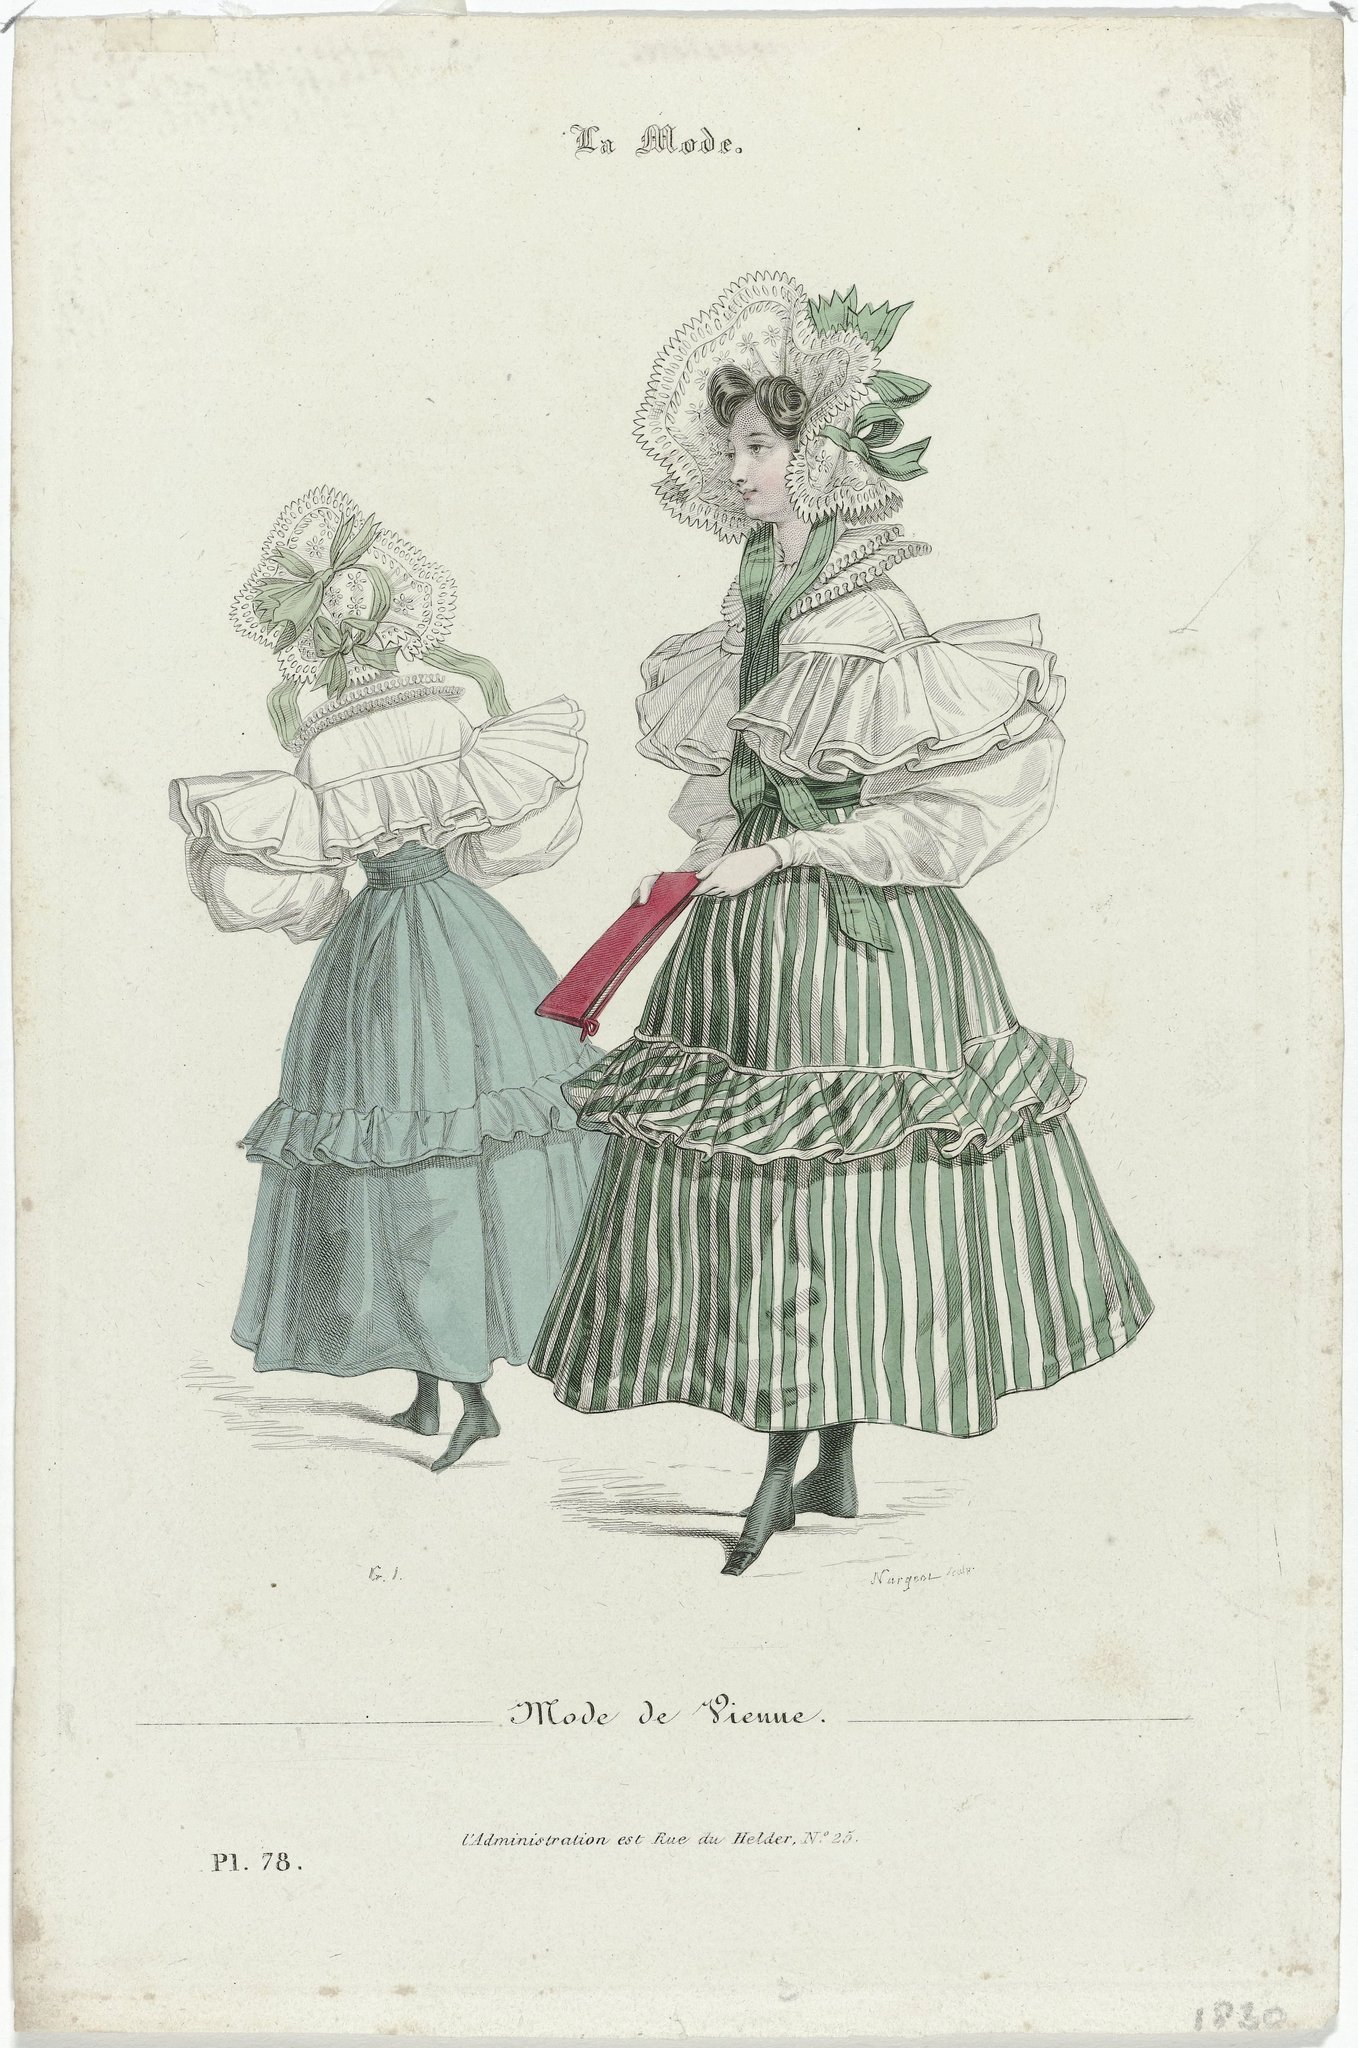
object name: fashion print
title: La Mode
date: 1830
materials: paper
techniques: hand coloring, engraving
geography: paris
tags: clothing for the upper part of the body: blouse (+ women's clothes), boots (+ women's clothes), head-gear: cap (+ women's clothes), fashion plates, neck-gear ~ clothing (with name) (+ women's clothes), skirt (+ women's clothes)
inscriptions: address: ‘L'Administration est Rue du Helder, No. 25.’, title: ‘La Mode.’, caption: ‘Mode de Vienne.’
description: On launching his society magazine La Mode (1829- 1955), the publisher Girardin criticized other fashion magazines for their ‘stiff, mechanical mannequins’. He wanted pictures that were more modern and animated. In illustrator Paul Gavarni, who had a reputation as the best-dressed man in Paris, he found just the right man to put a fresh spin on the fashion plate and to make the stiff ‘mannequins’ come to life.